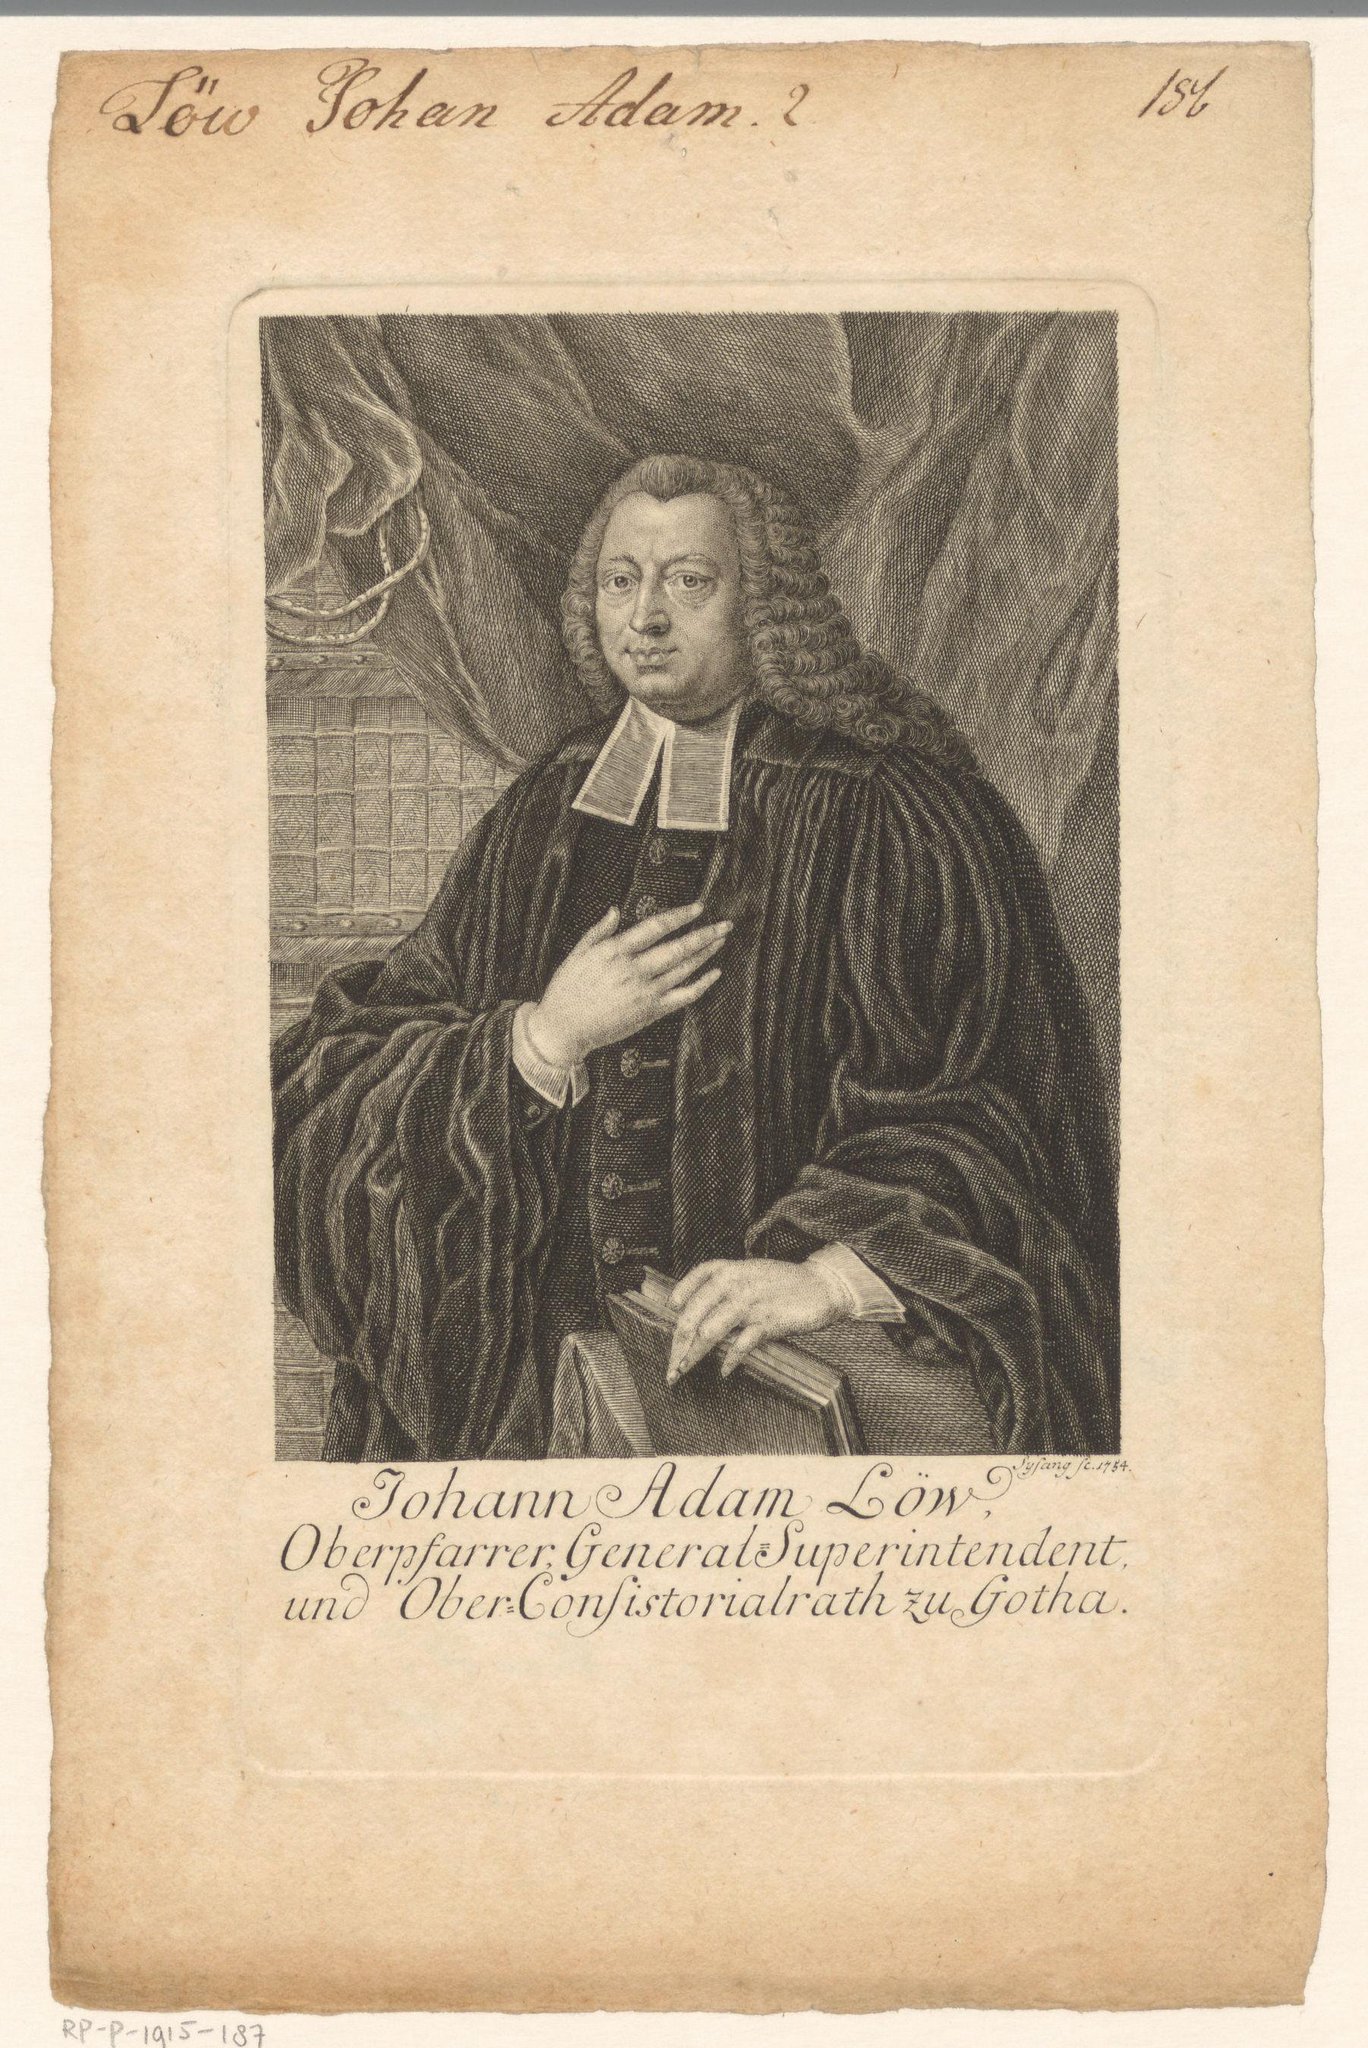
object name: print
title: Portret van Johann Adam Löw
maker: johann christoph sysang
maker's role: print maker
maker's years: 1703-1757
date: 1754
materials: paper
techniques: engraving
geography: leipzig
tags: bookshelves, historical persons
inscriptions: collector's mark: Lugt 2228, number: ‘156’